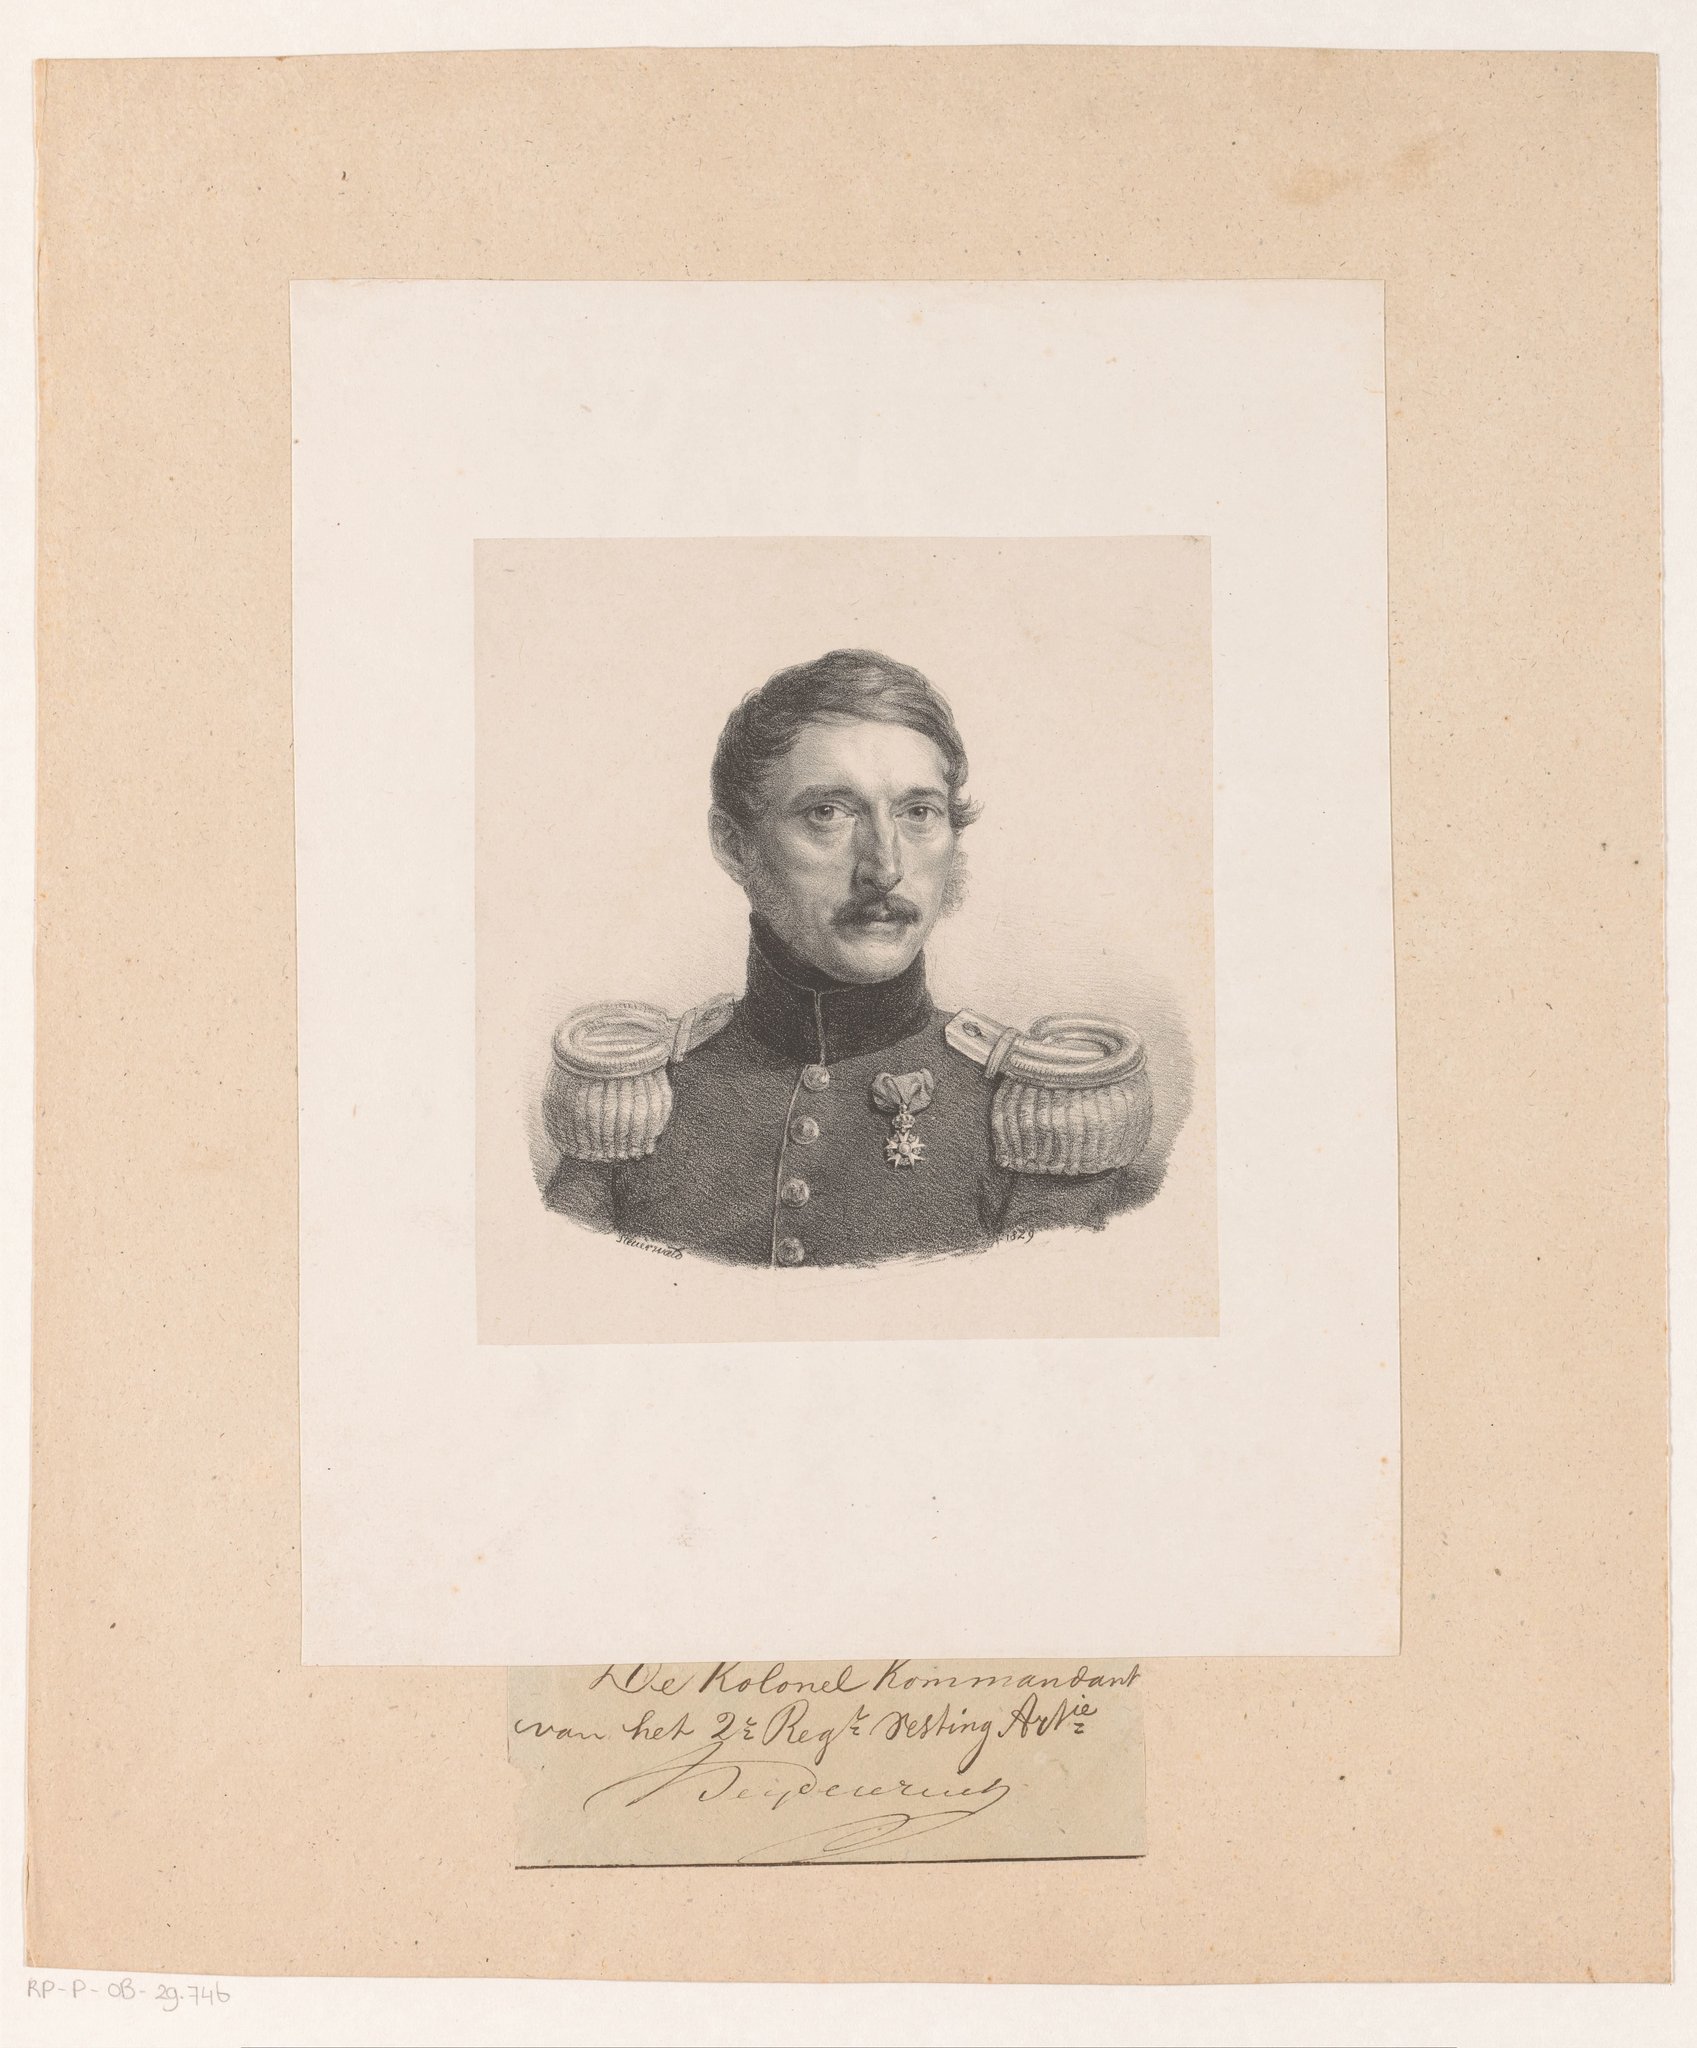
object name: print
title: Portret van kolonel kommandant Heydenreich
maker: christian heinrich gottlieb steuerwald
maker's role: draughtsman, print maker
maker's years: 1802-1874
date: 1829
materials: paper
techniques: lithograph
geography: dordrecht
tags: historical persons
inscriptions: collector's mark: Lugt 2228